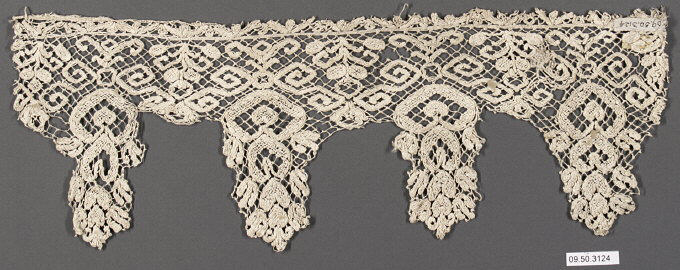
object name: fragment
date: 1601-1700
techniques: embroidery